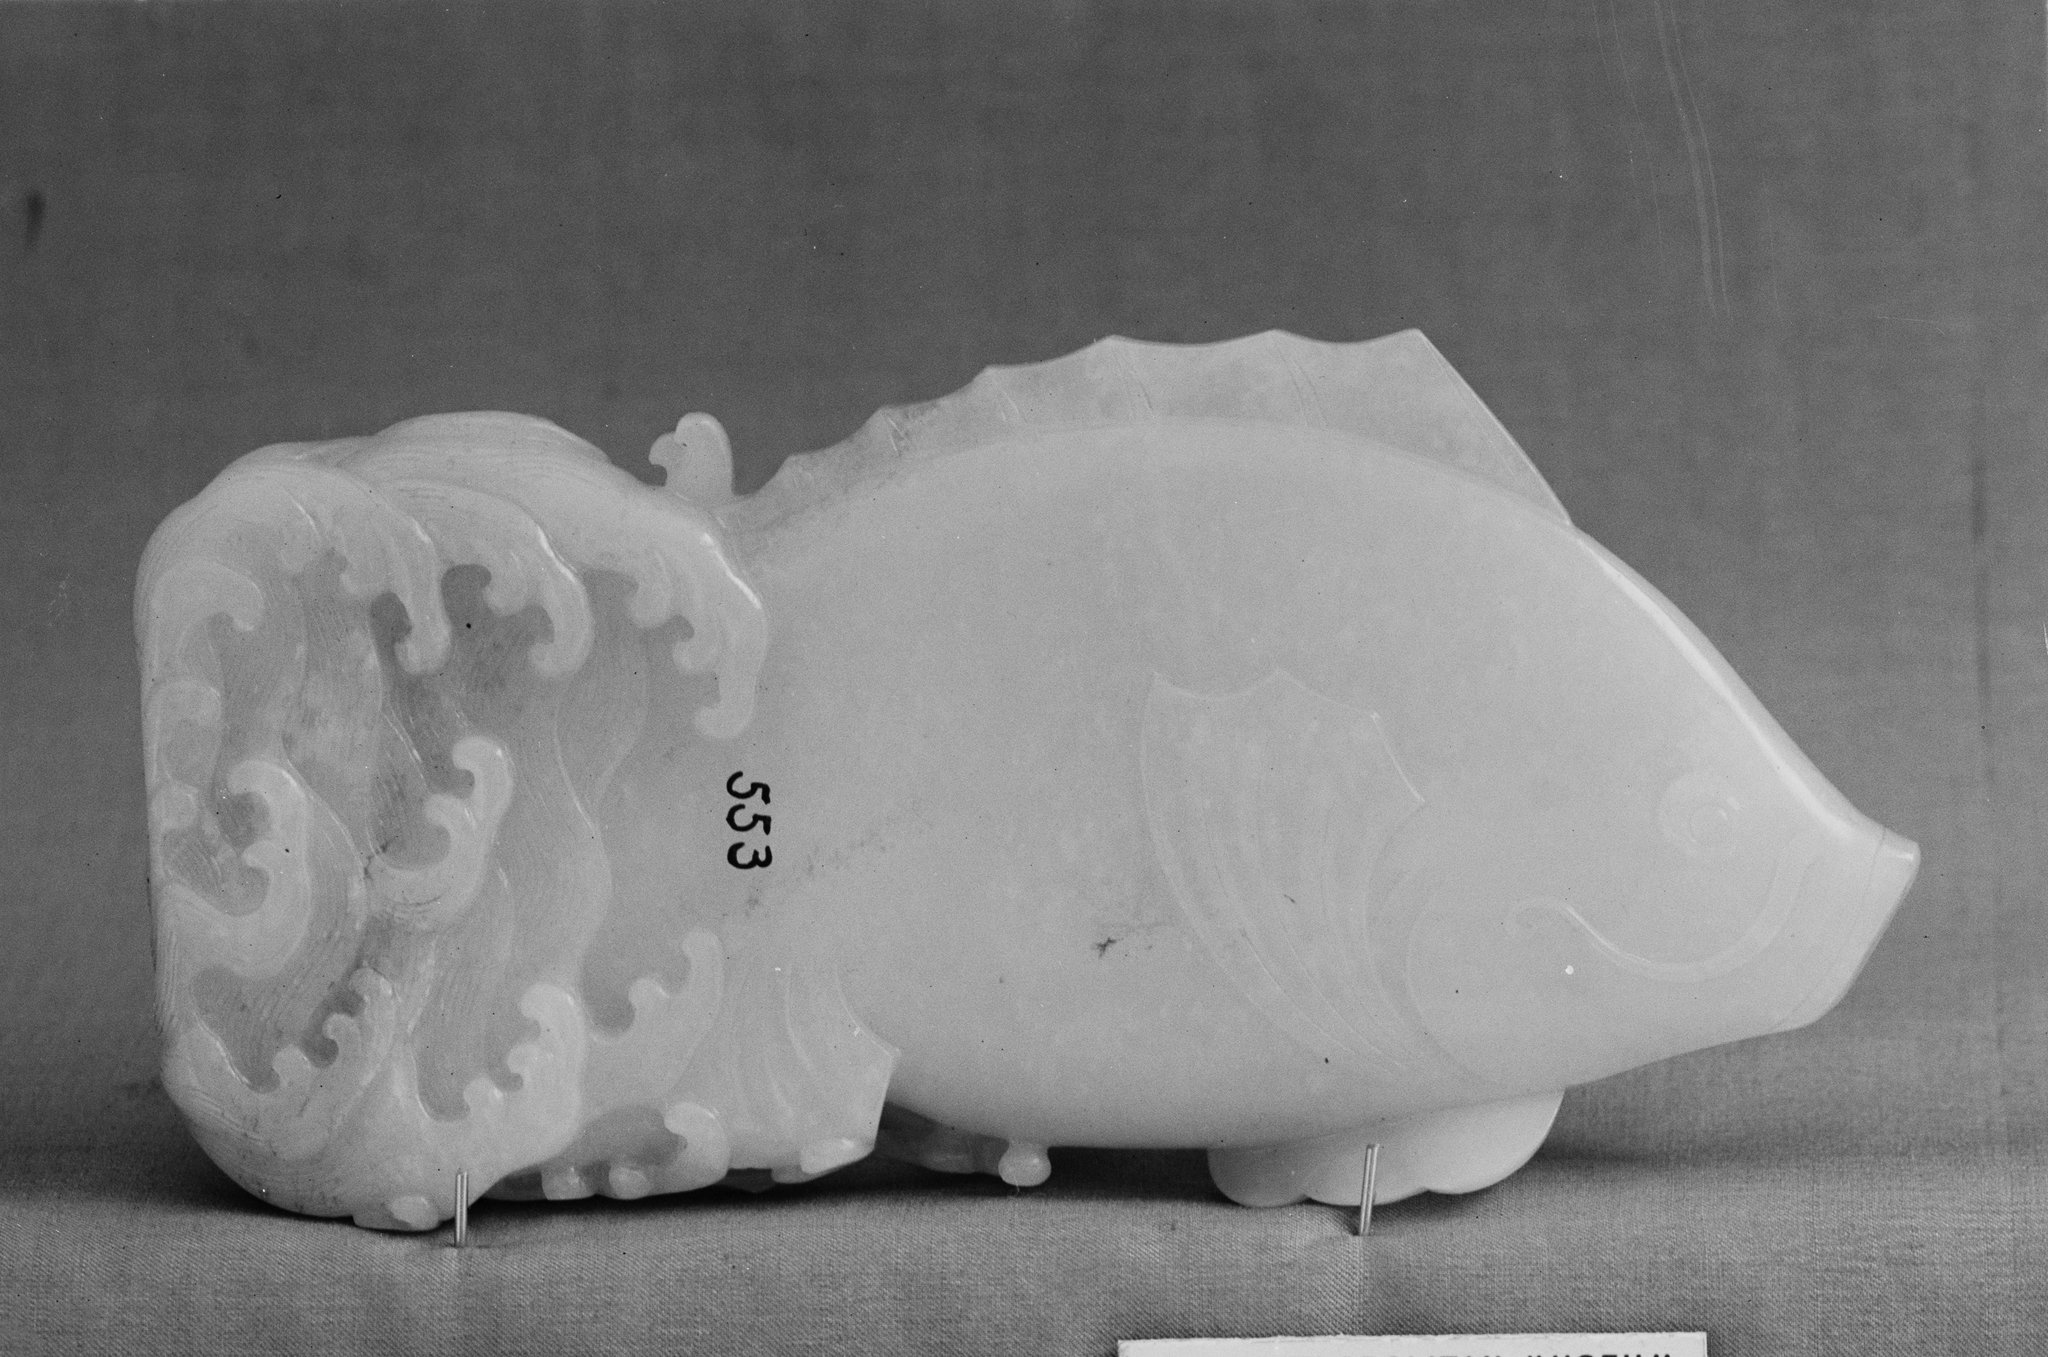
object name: plaque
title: Ornamental Plaque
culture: chinese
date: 1736-1795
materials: jade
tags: fish